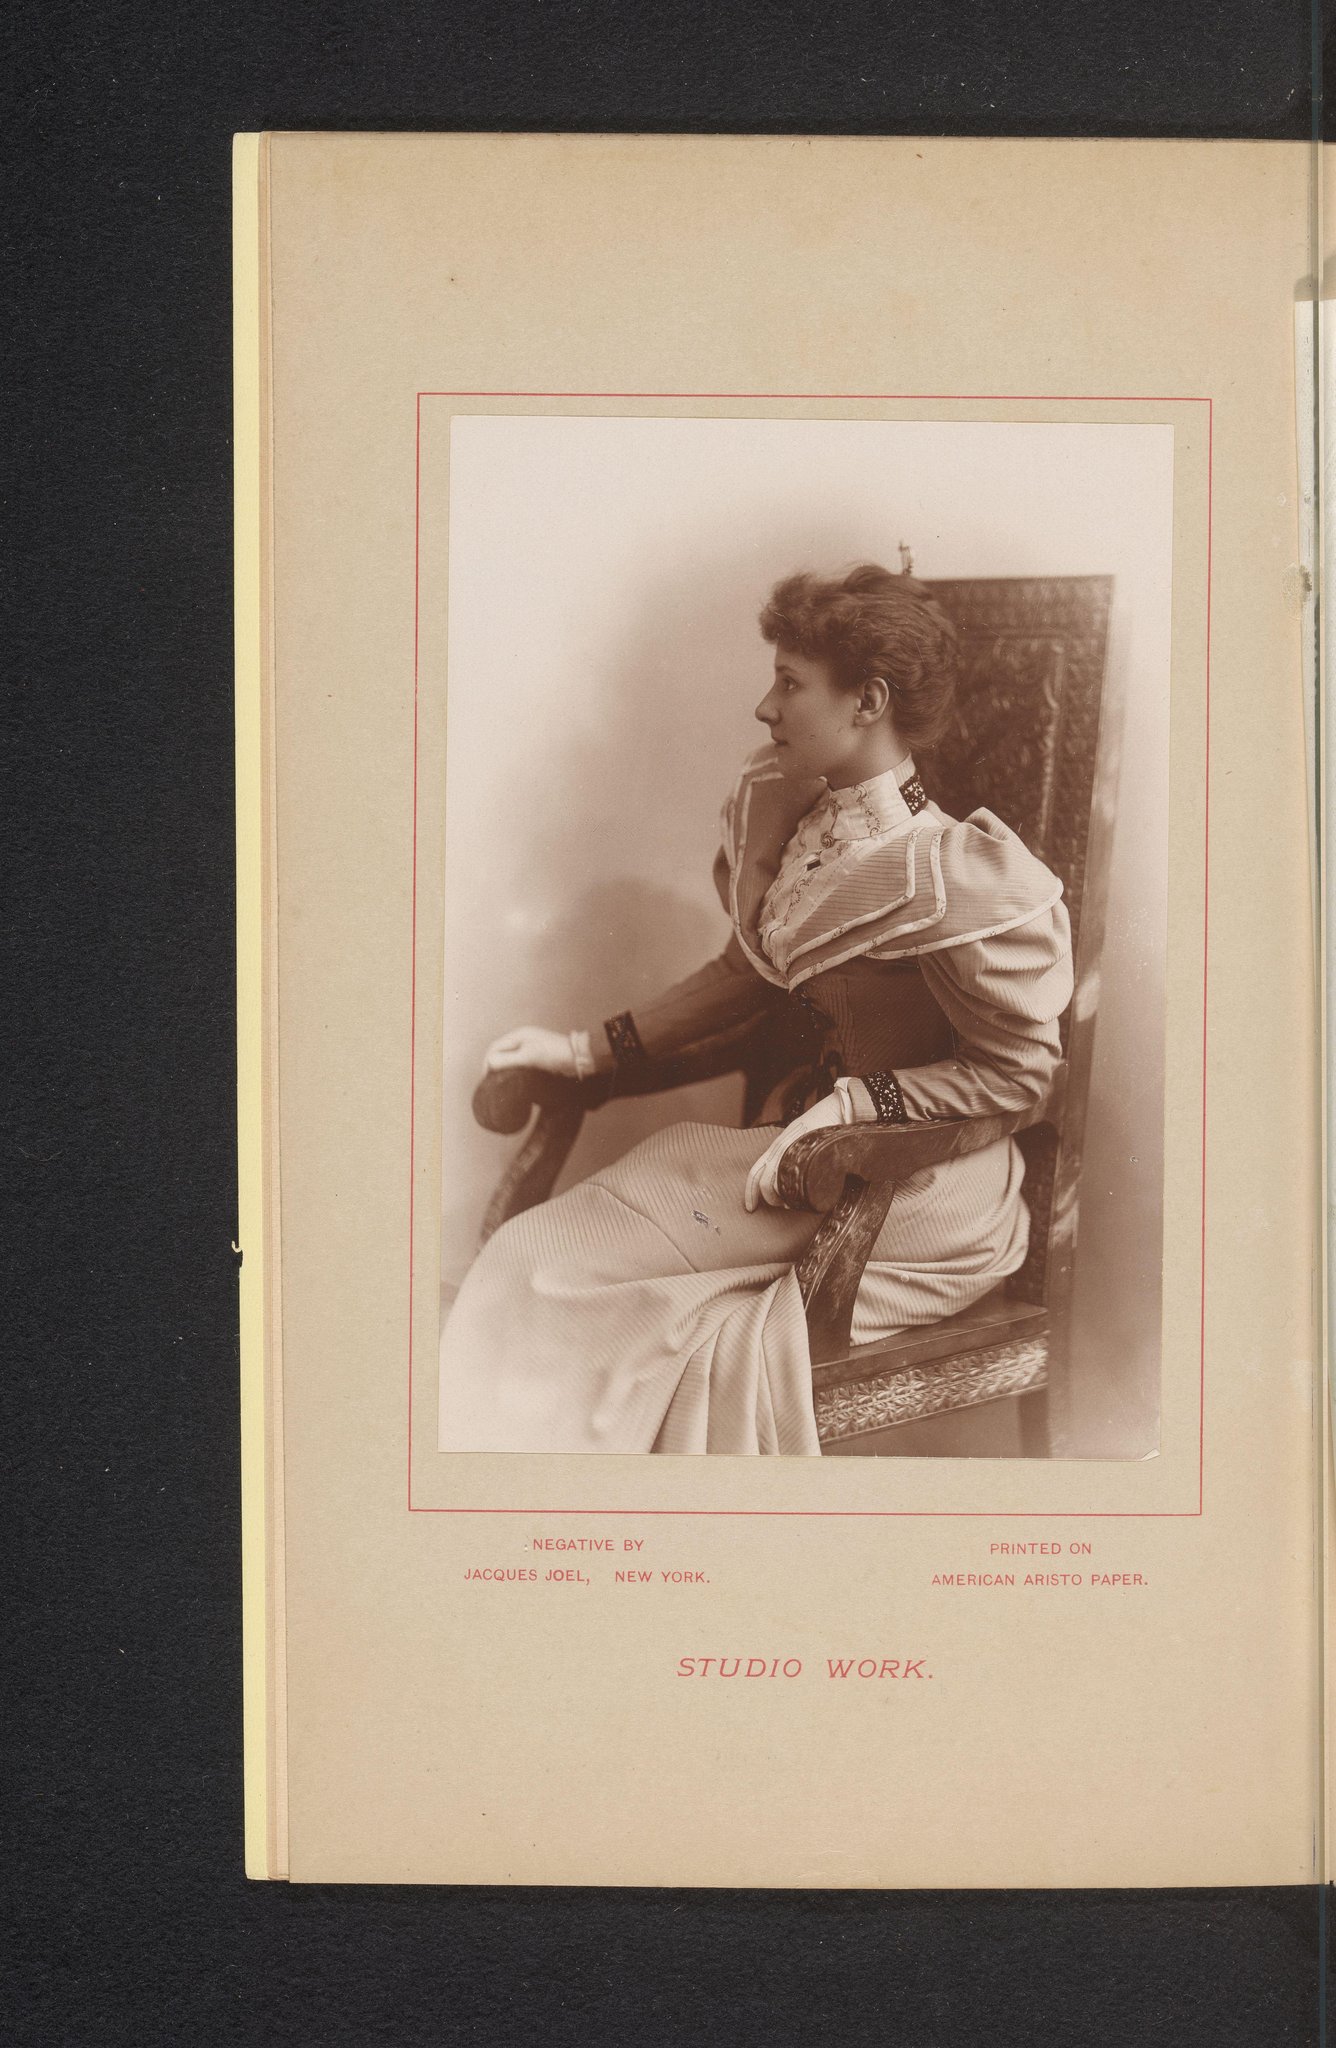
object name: page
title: Studio work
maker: jacques joel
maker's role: fotograaf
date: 1888-1893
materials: photographic support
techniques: collodion silver print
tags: adult woman, historical persons, chair